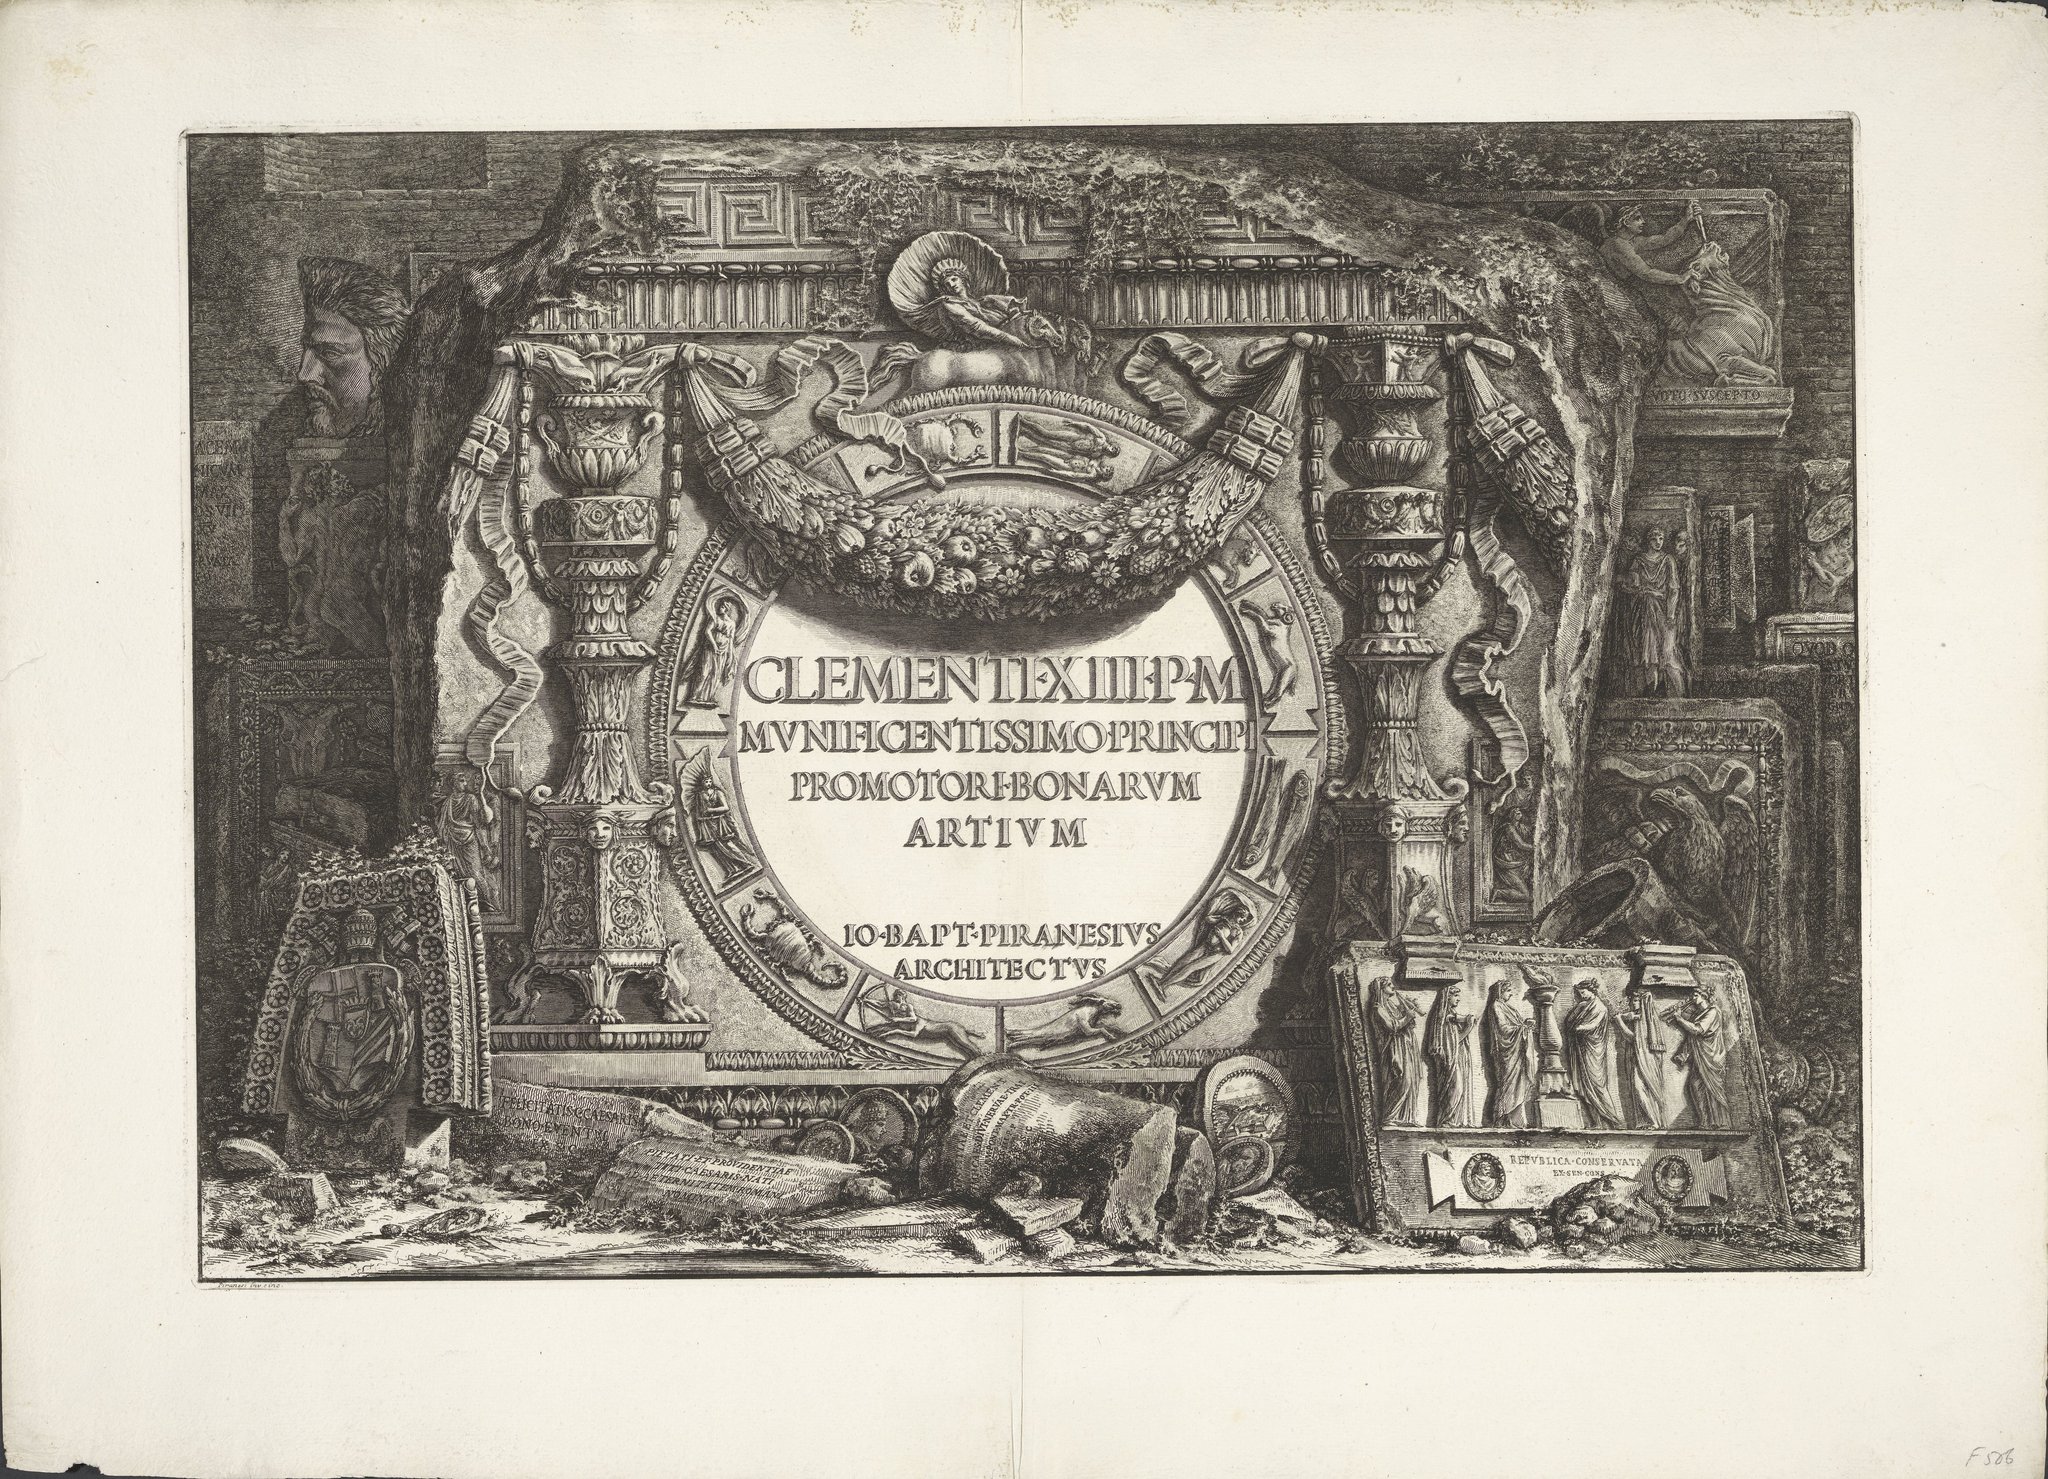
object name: titelprent, frontispice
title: Archeologische vondsten uit Albano en Castel Gandolfo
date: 1764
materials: paper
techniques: etching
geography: rome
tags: ornaments ~ art, piece of sculpture, reproduction of a piece of sculpture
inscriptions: collector's mark: Lugt 2228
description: Deze prent maakt deel uit van de serie van 33 prenten (inclusief titelprent, opdracht, vignet en ornamentele letter) met de titel 'Antichità d'Albano e di Castel Gandolfo'.